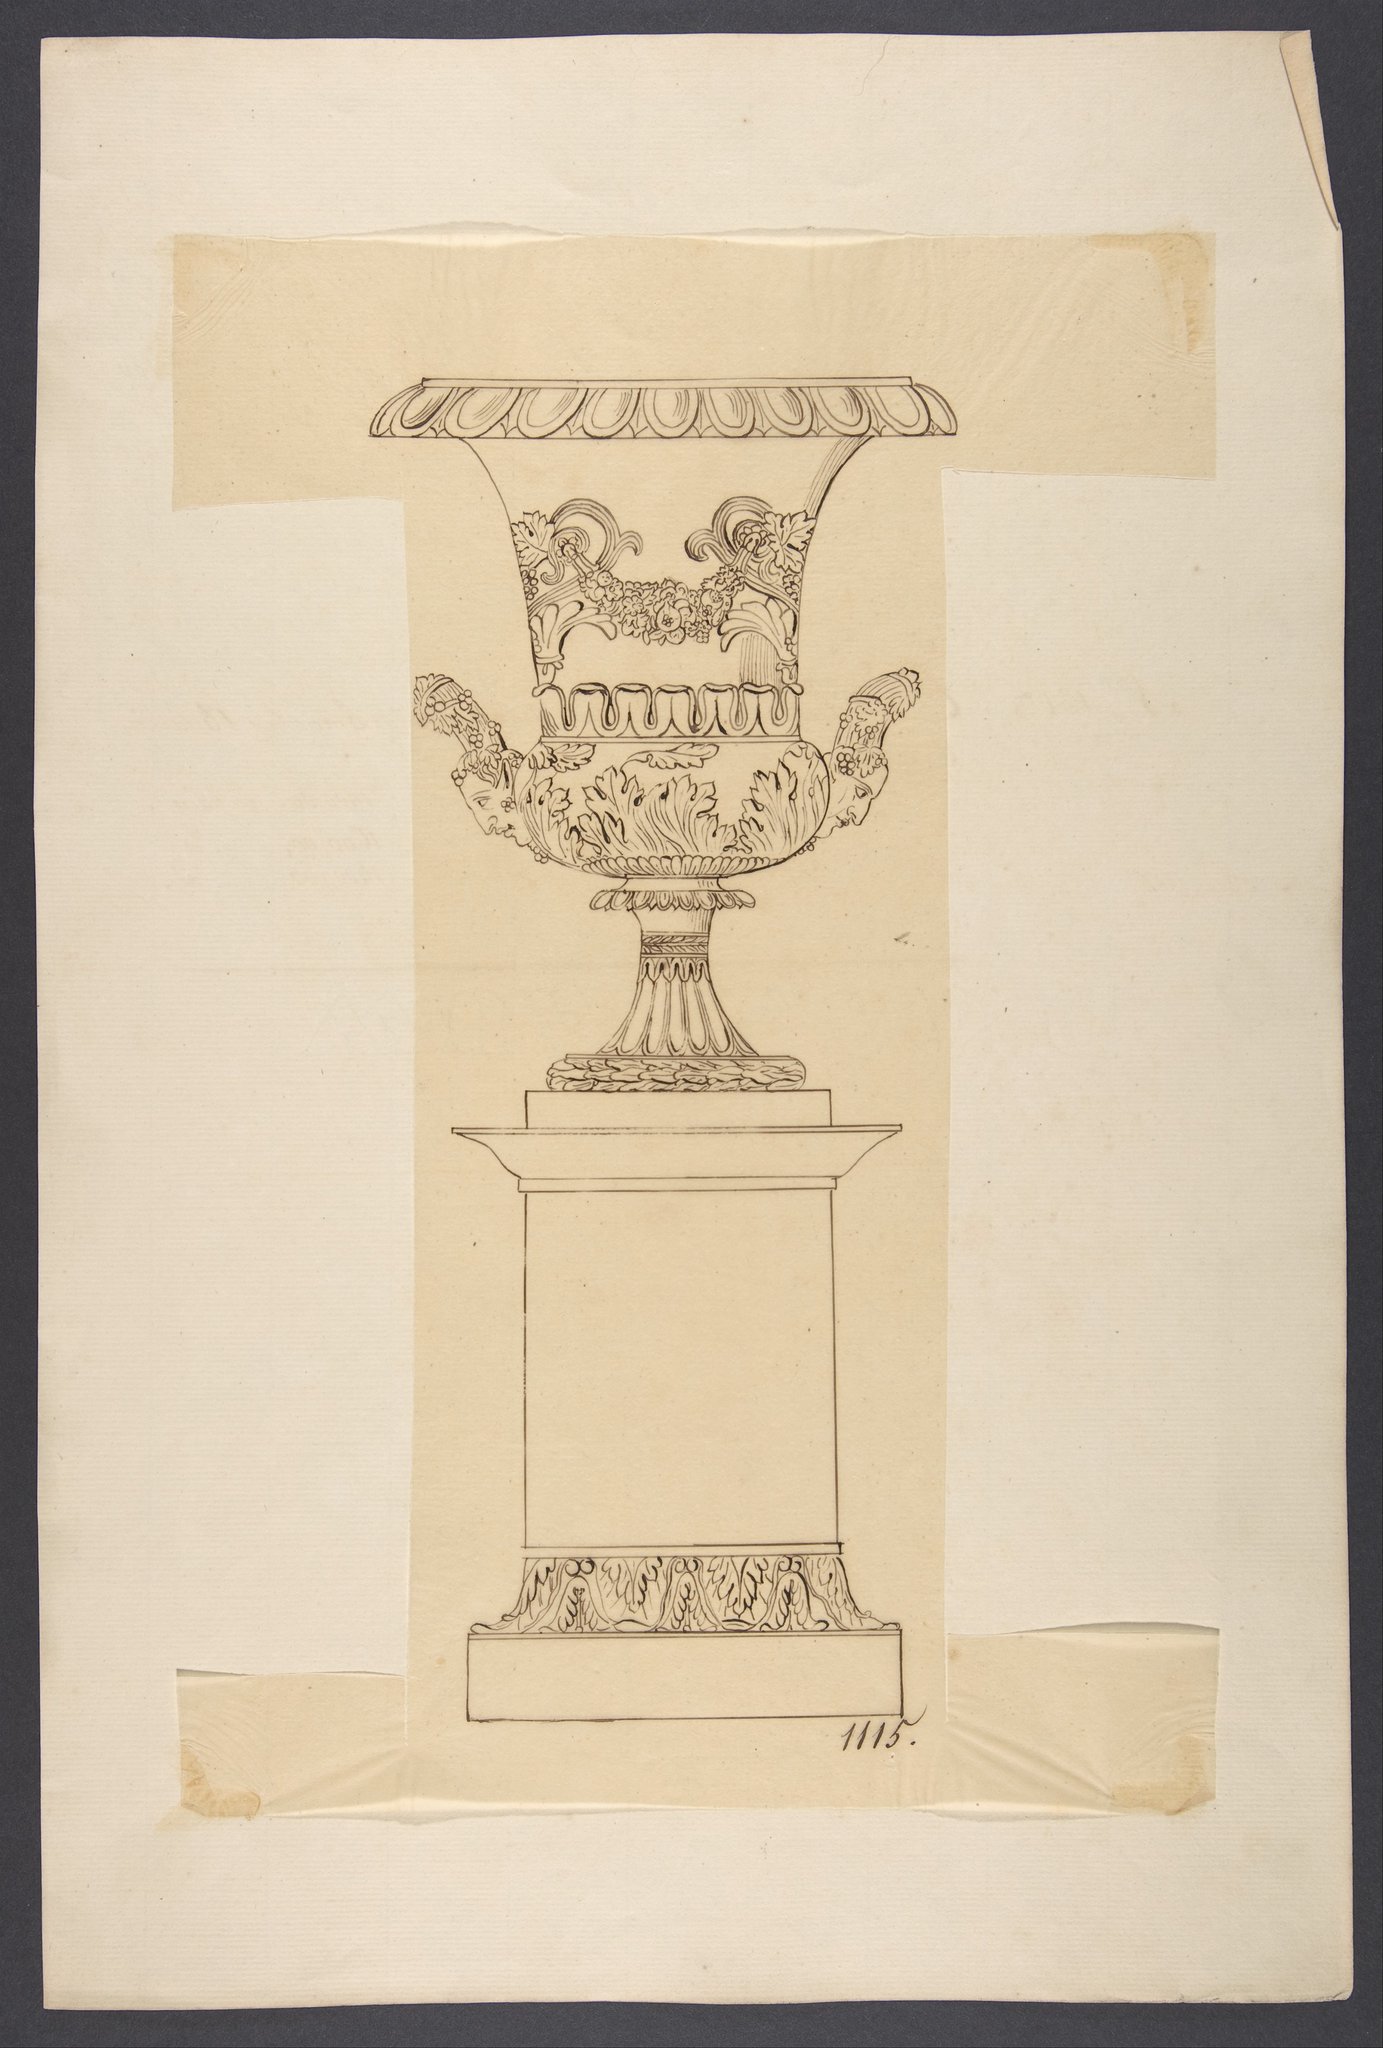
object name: drawing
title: Design for an Urn on a Pedestal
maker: anonymous, french, 19th century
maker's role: artist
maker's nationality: french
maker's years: 1800-1900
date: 1801-1900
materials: ink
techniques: pen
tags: ornament,urns